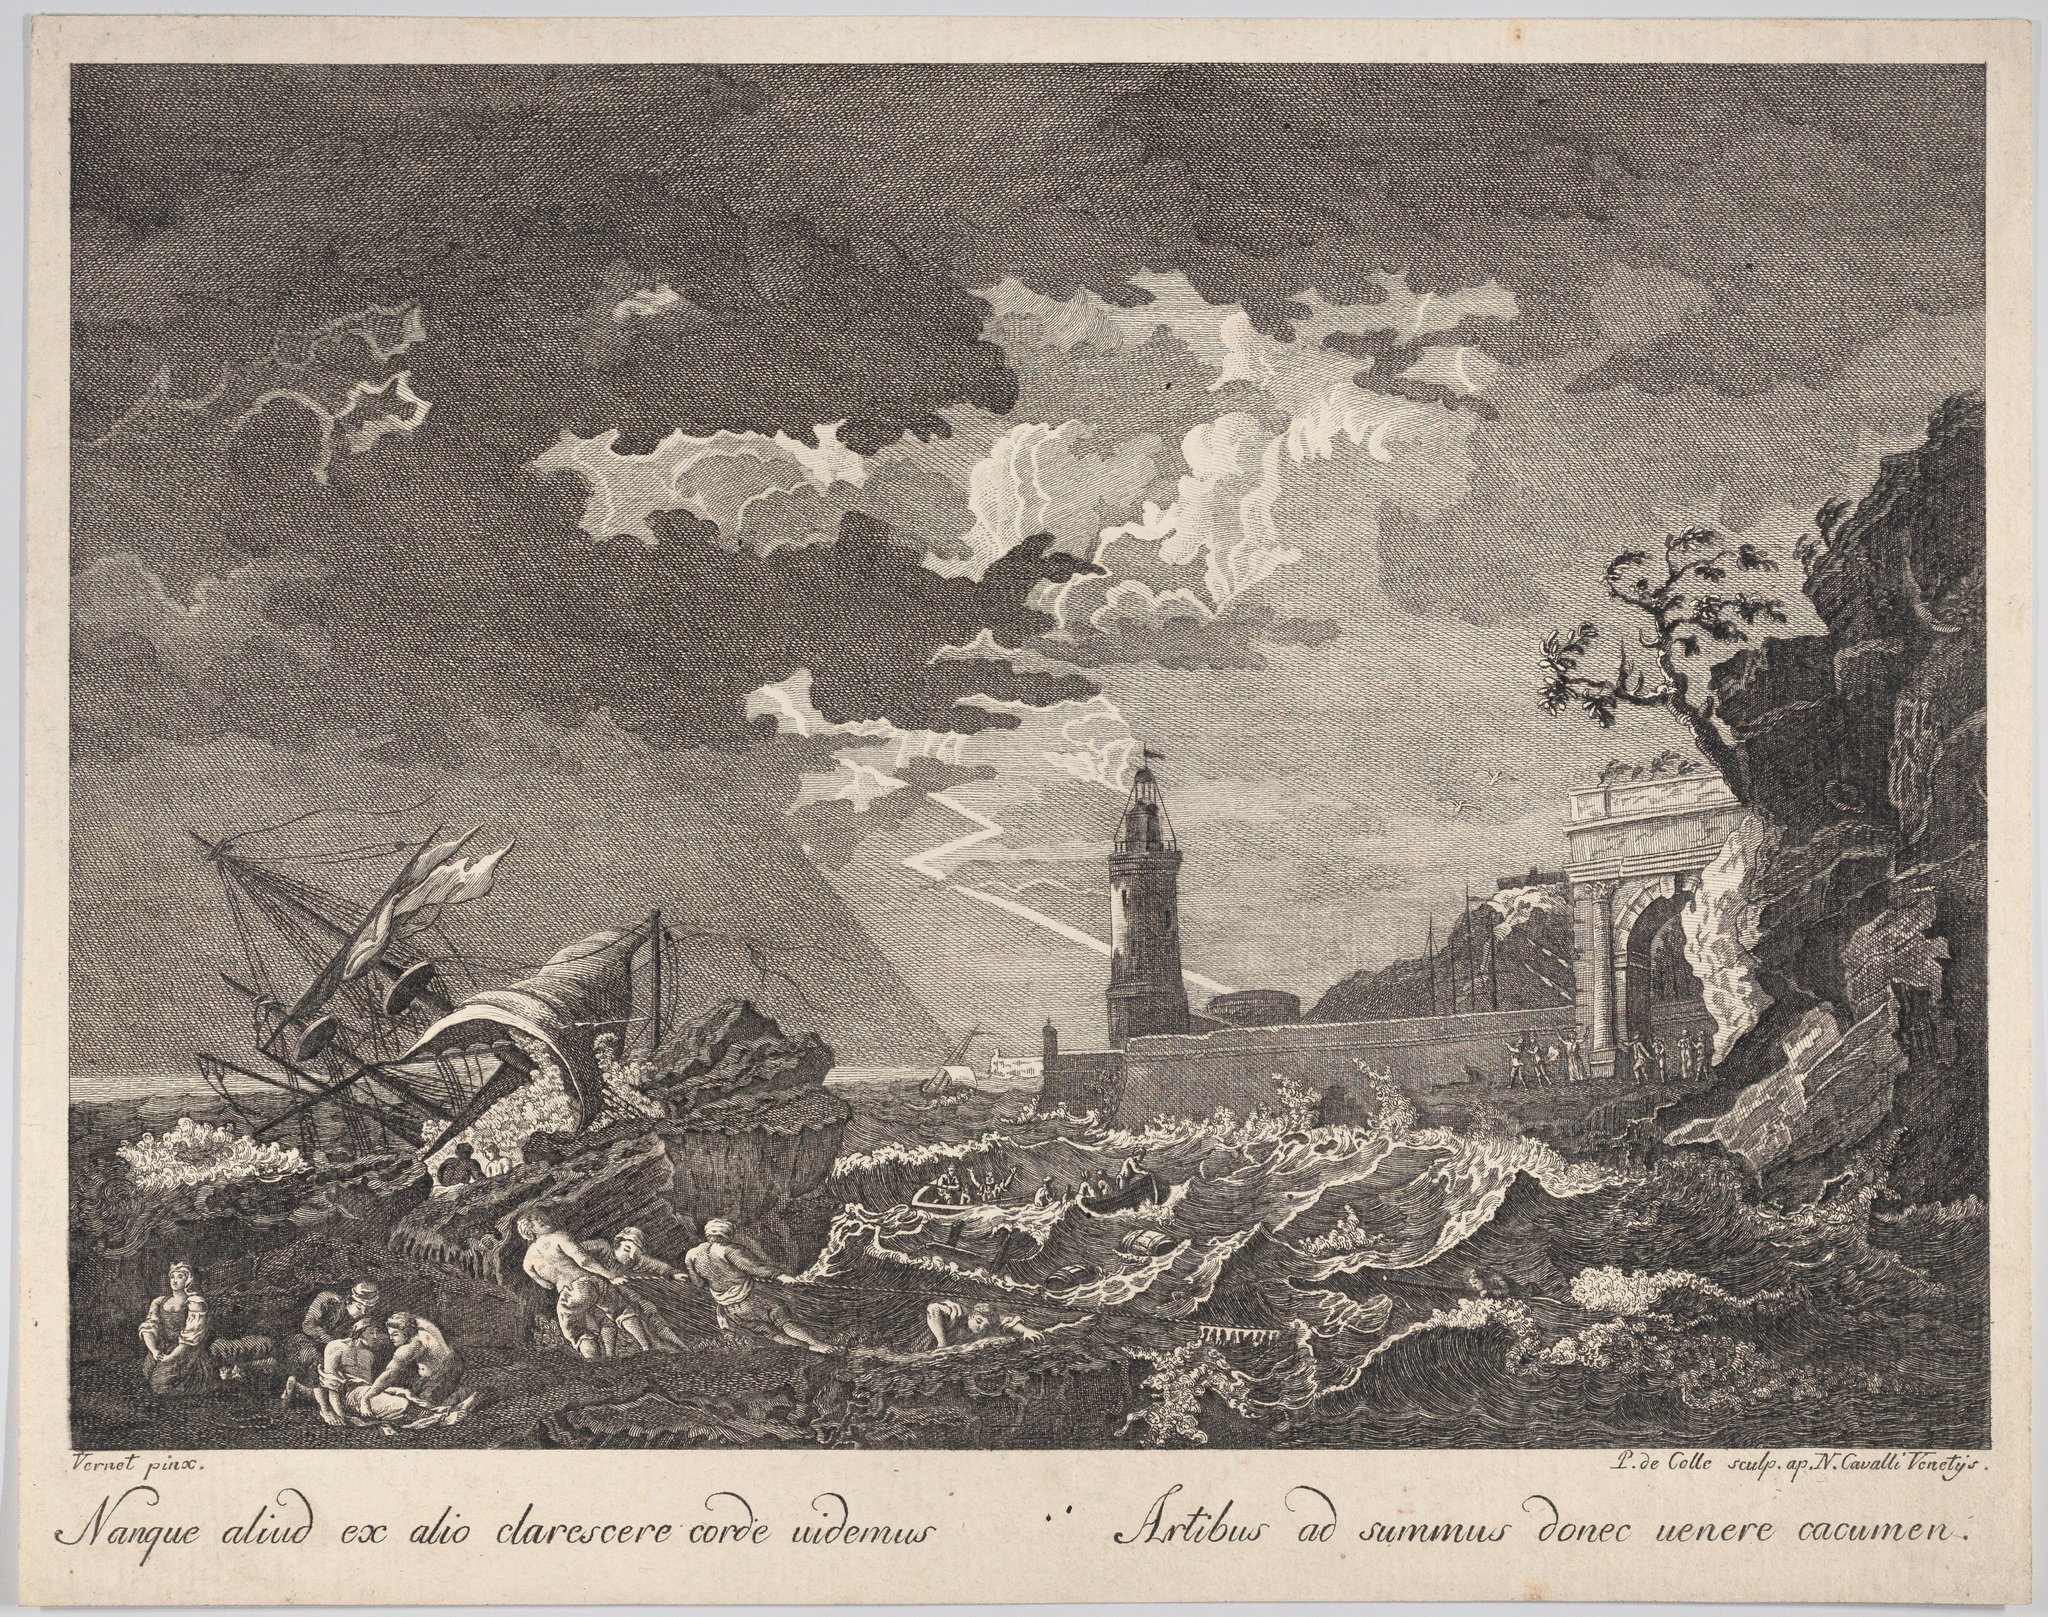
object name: print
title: Nanque aliud ex alio clarescere corde uidemus. Artibus ad summus donec uenere cacumen.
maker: joseph vernet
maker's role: artist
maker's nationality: french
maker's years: 1714-1789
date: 1750-1800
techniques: engraving